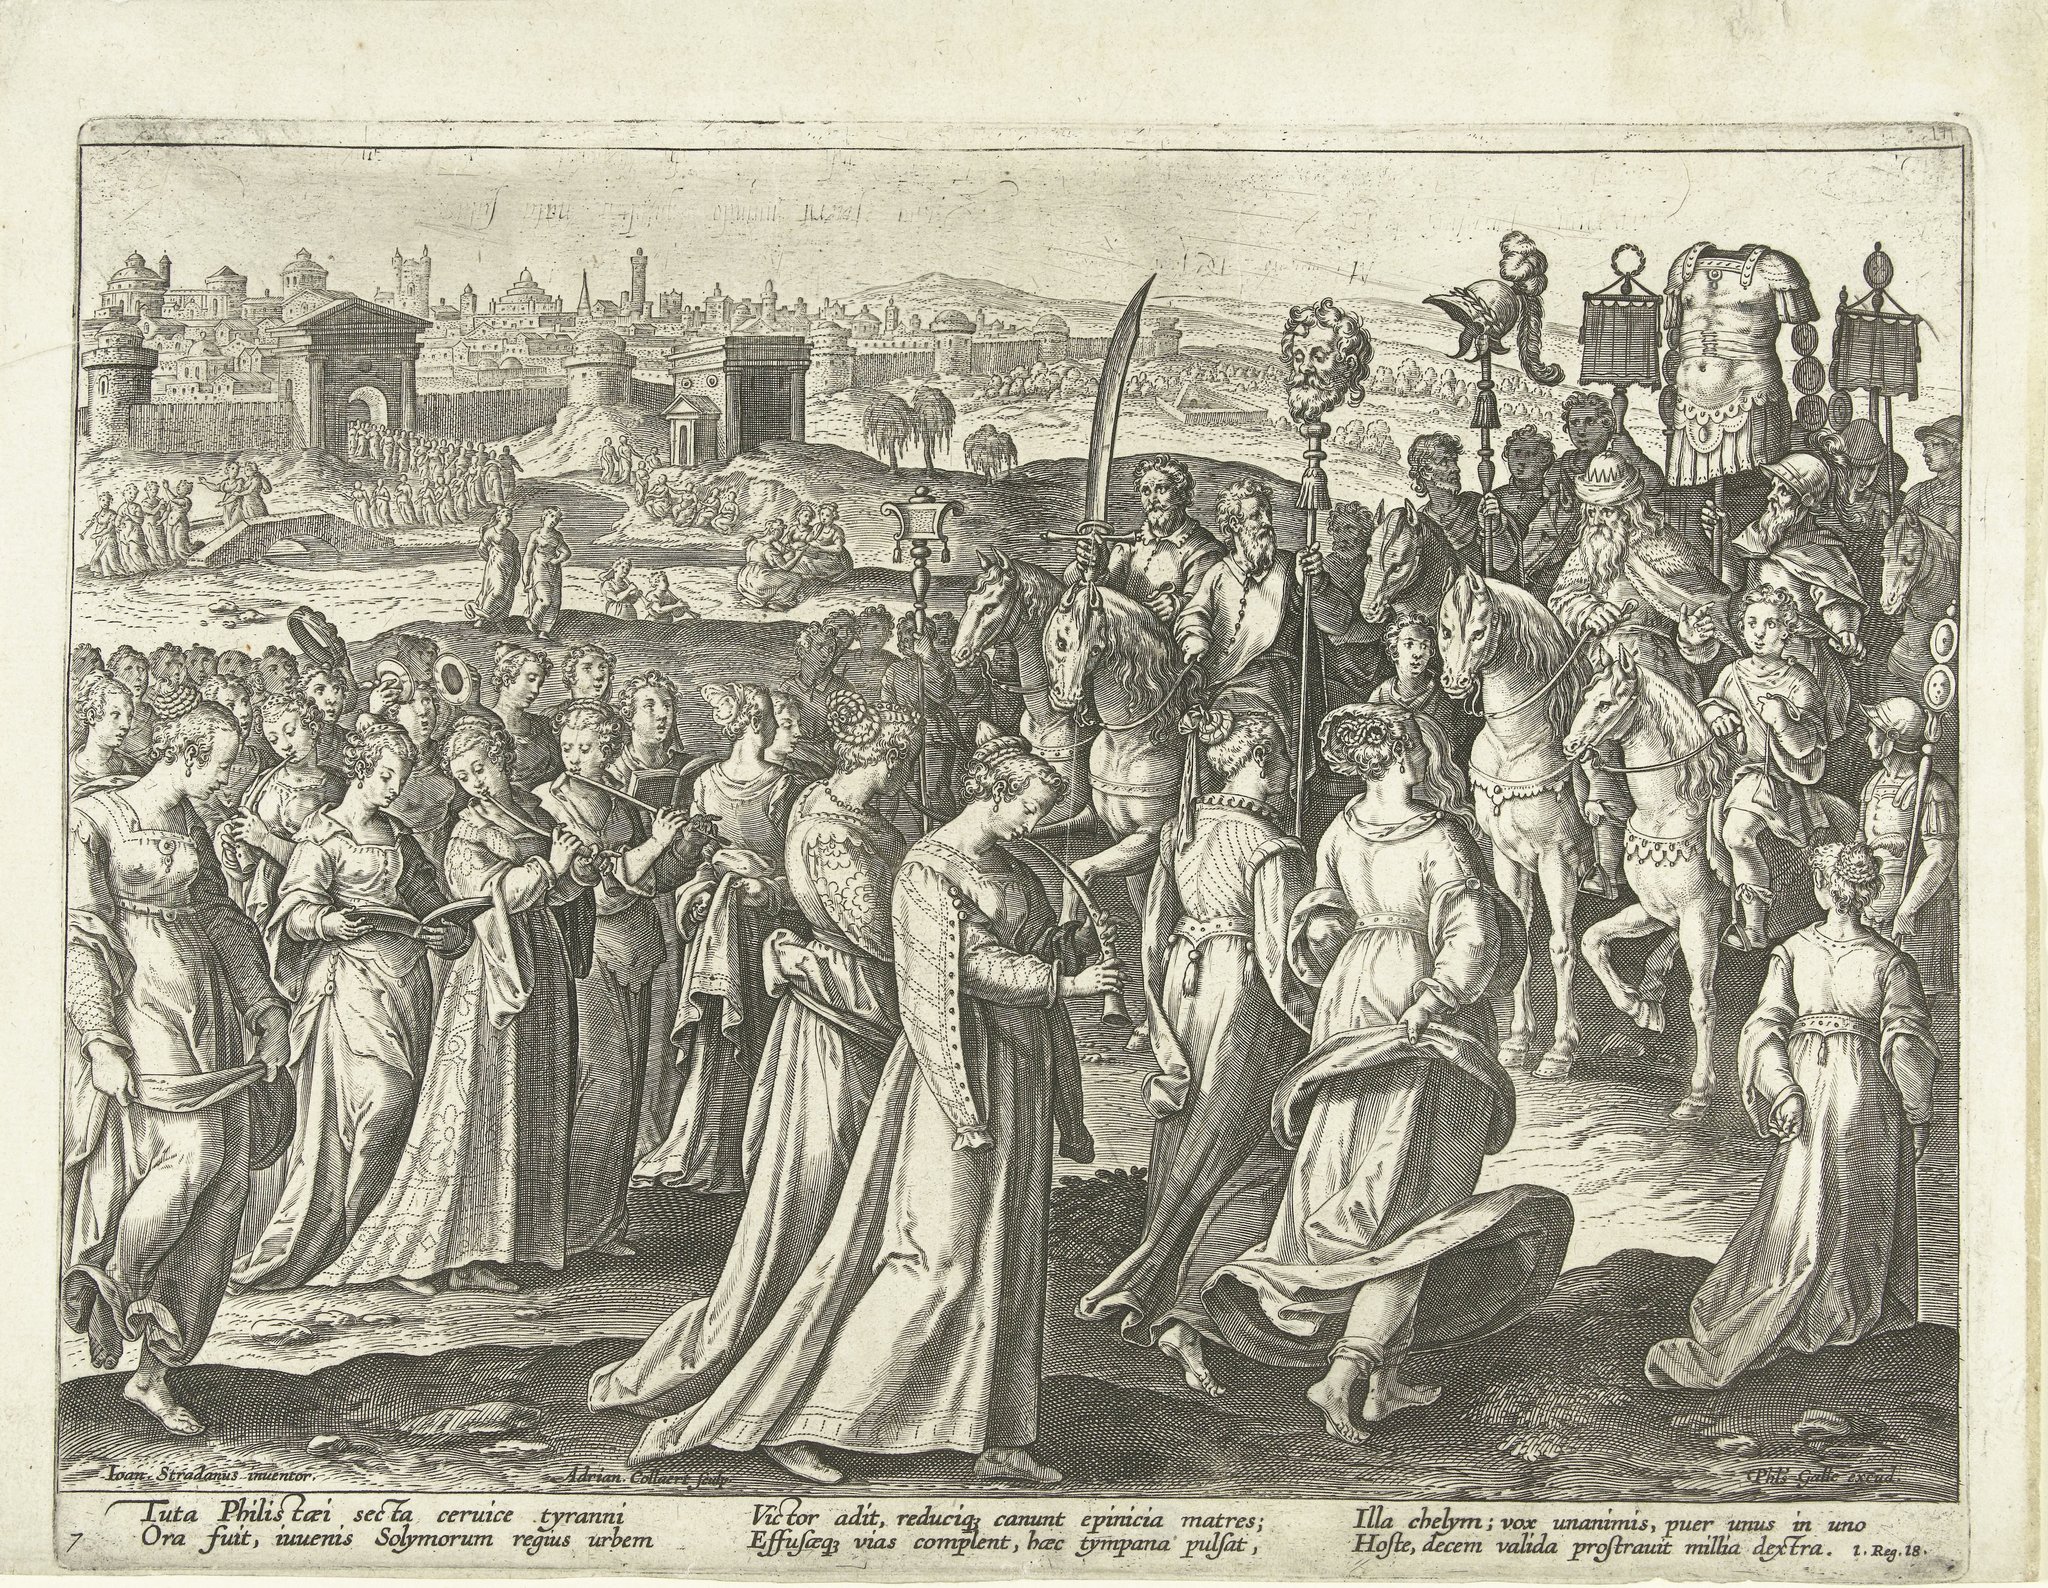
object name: print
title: Encomium Musices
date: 1587-1591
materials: paper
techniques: engraving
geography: antwerp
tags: david's triumph: the women of israel come out to welcome david, singing, dancing, and playing tambourines and lyres; david holding the head of goliath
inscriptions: collector's mark: Lugt 1425, collector's mark: Lugt 2228, collector's mark: Lugt 2760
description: Na Davids overwinning tegen Goliat en de Filistijnen worden koning Saul en David feestelijk onthaald door de vrouwen van Israël (1 Samuël 18:6-7). De wapenrusting en het hoofd van Goliat worden triomfantelijk meegedragen. De prent heeft een Latijns onderschrift met verzen. De prent is deel van een serie met scènes uit het Oude Testament die te maken hebben met muziek.